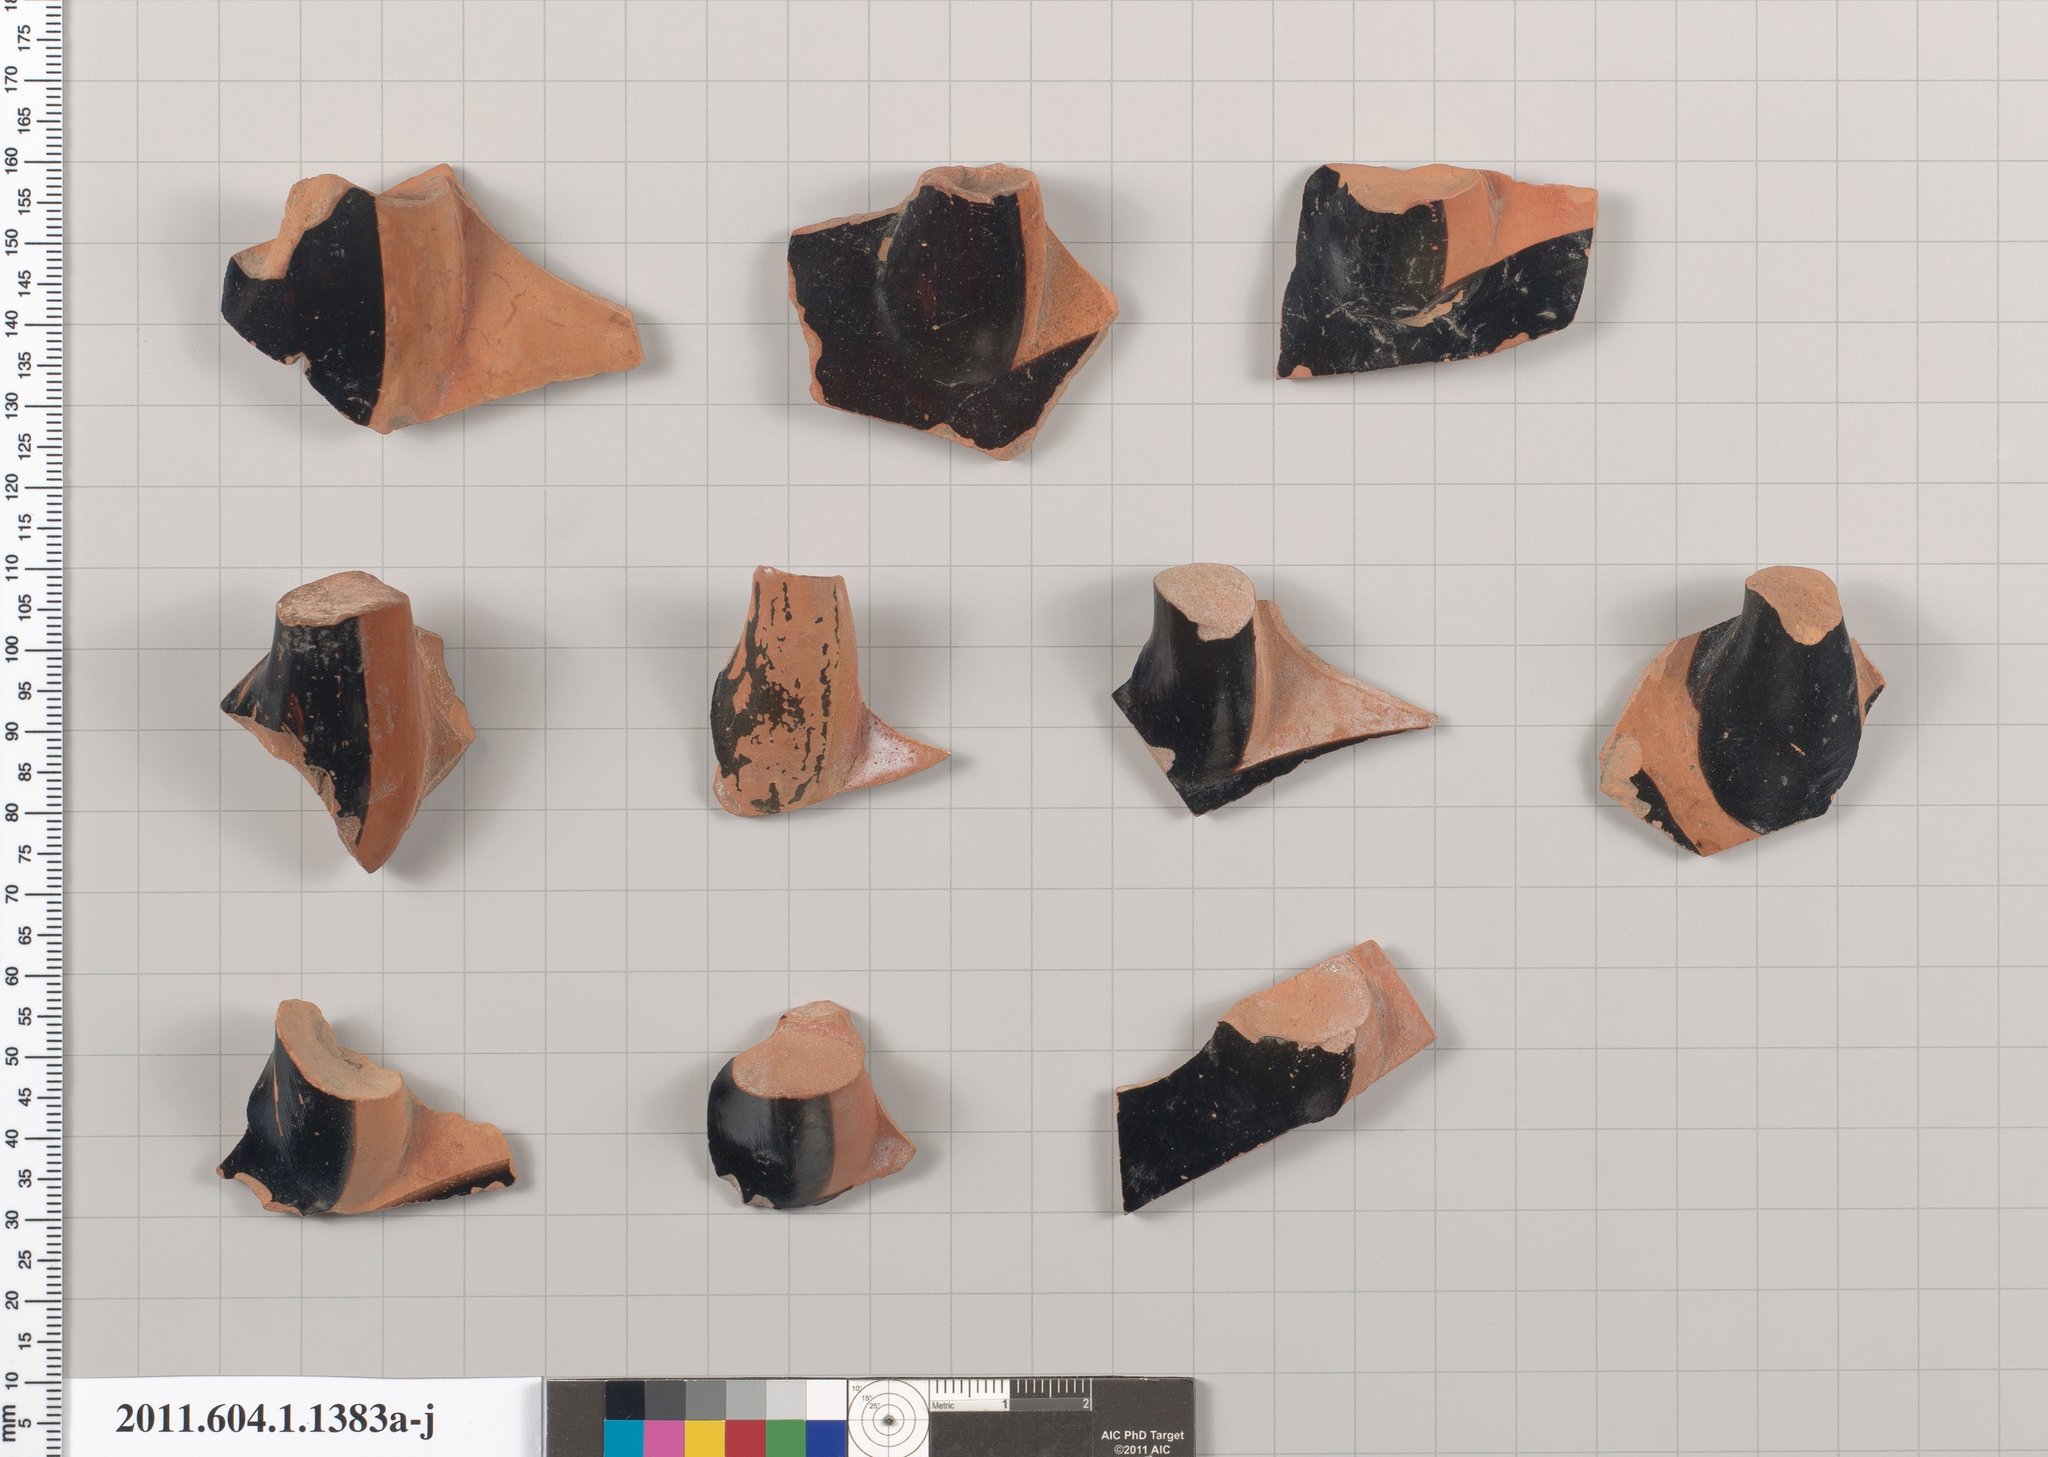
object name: kylix fragment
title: Terracotta fragments of kylikes (drinking cups)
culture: greek, attic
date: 500-401 BCE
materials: terracotta